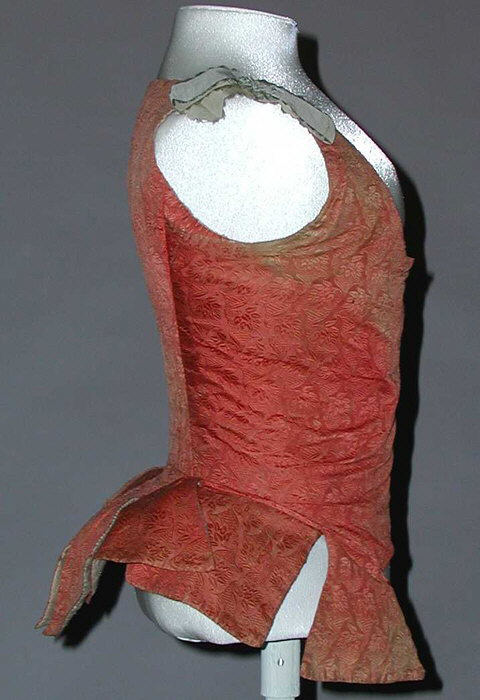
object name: bodice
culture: european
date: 1701-1800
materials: silk